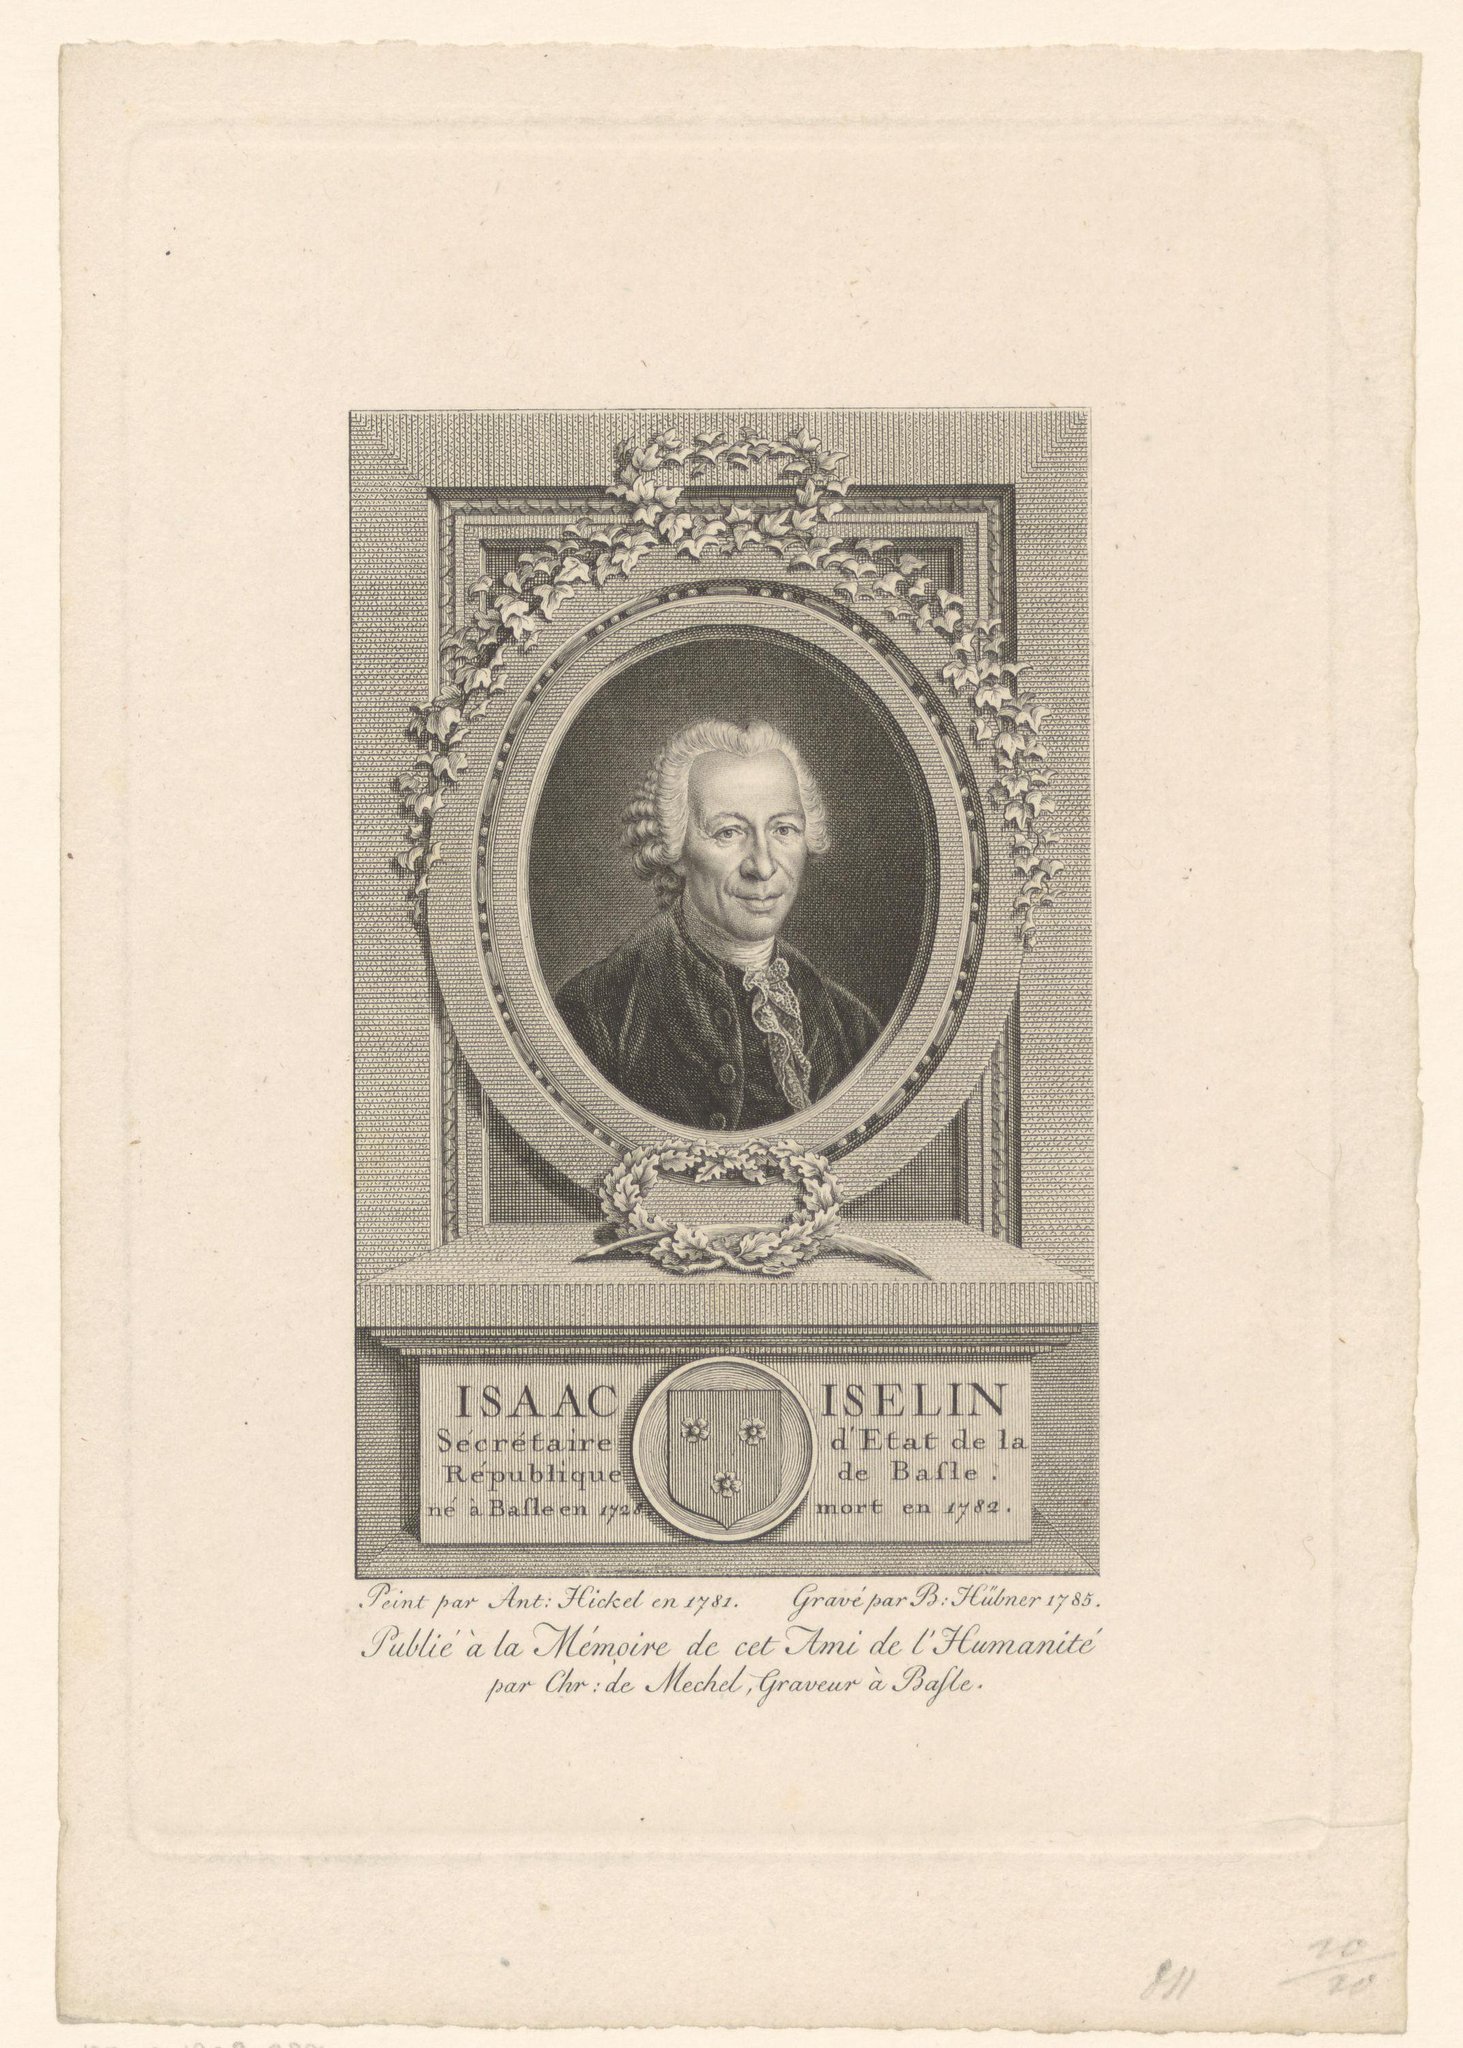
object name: print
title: Portret van Isaak Iselin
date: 1785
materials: paper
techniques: engraving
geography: basel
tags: ornament ~ medallion, historical persons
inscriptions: collector's mark: Lugt 2228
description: Tekst in het Frans onder het ovale medaillon.